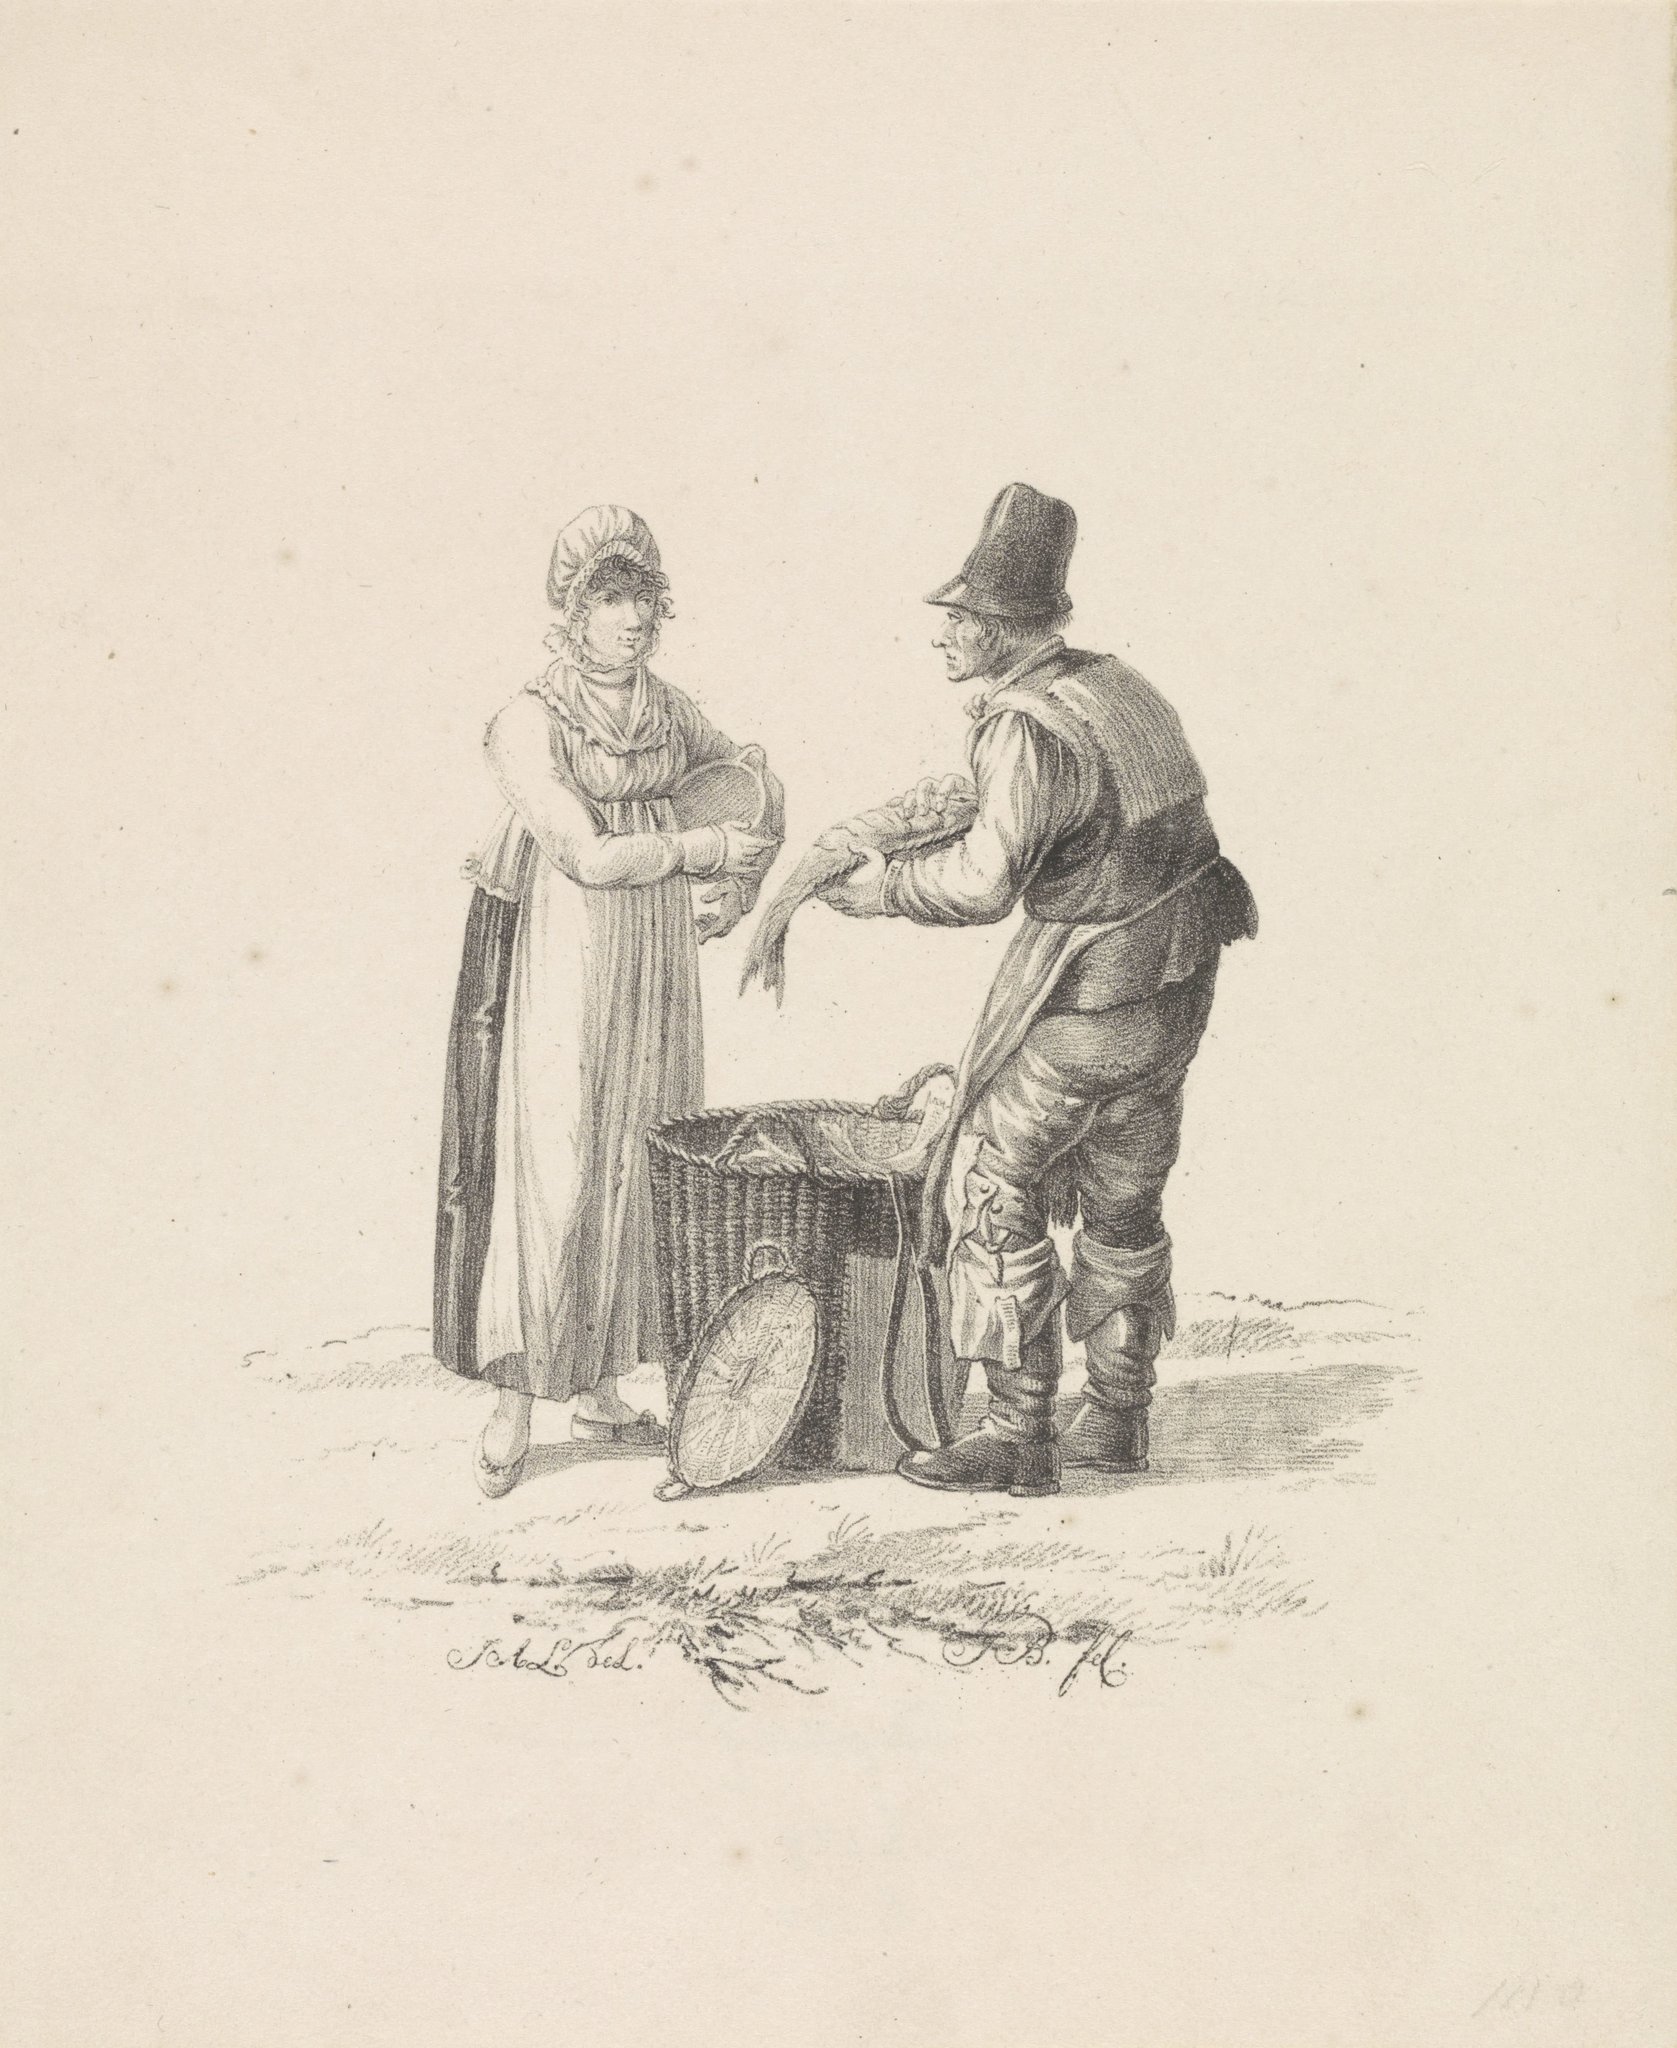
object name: print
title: Visverkoper met klant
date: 1809-1841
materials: paper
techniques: lithograph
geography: netherlands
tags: fishes, container made of plant material other than wood: basket, merchant, salesman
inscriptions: collector's mark: Lugt 2228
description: De man, op de rug gezien, biedt een meisje een vis aan. Het meisje heeft een schaal onder haar arm. Tussen hen in staat een mand.